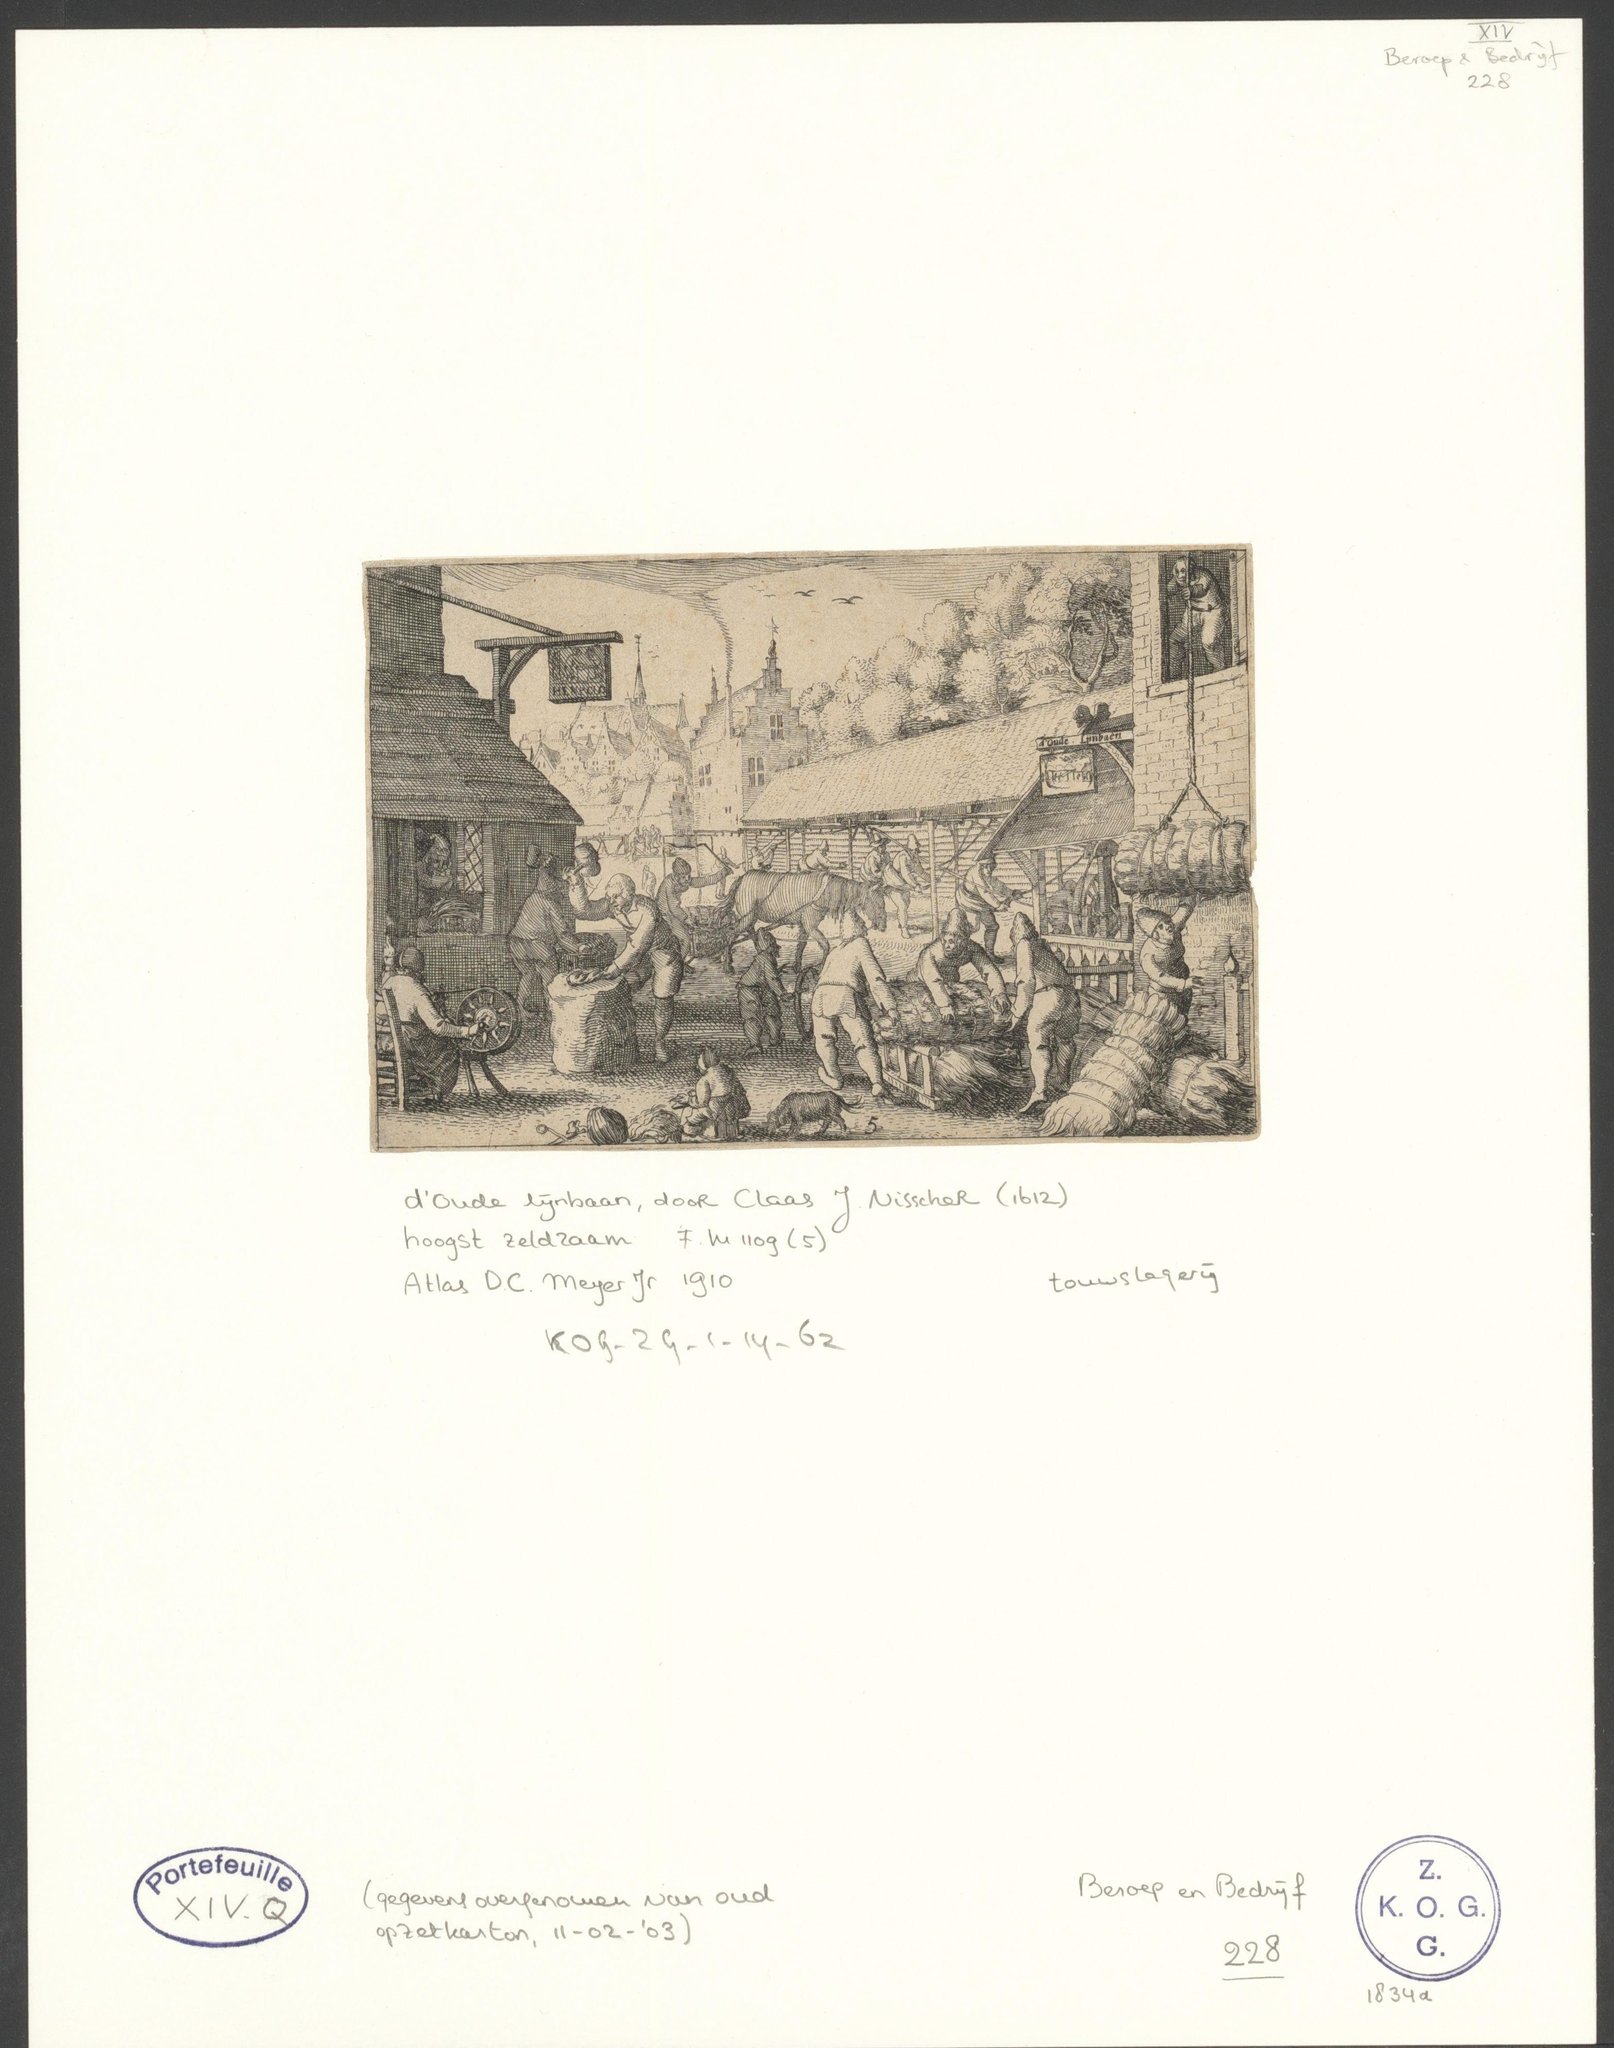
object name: print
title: Het Menselyk Bedryf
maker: jan luyken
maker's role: draughtsman, print maker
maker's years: 1649-1712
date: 1694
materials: paper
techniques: engraving, etching, letterpress printing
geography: netherlands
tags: ropery, rope-walk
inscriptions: collector's mark: Lugt 1641, collector's mark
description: Een lijndraaier of touwslager aan het werk op een lijnbaan. Onderaan een zesregelig vers. Bedrukt met tekst op verso. Onderwerpsrubrieken binnen de Atlas Zeden en Gewoonten: Mannelijk beroep en bedrijf: Touwslagerij.